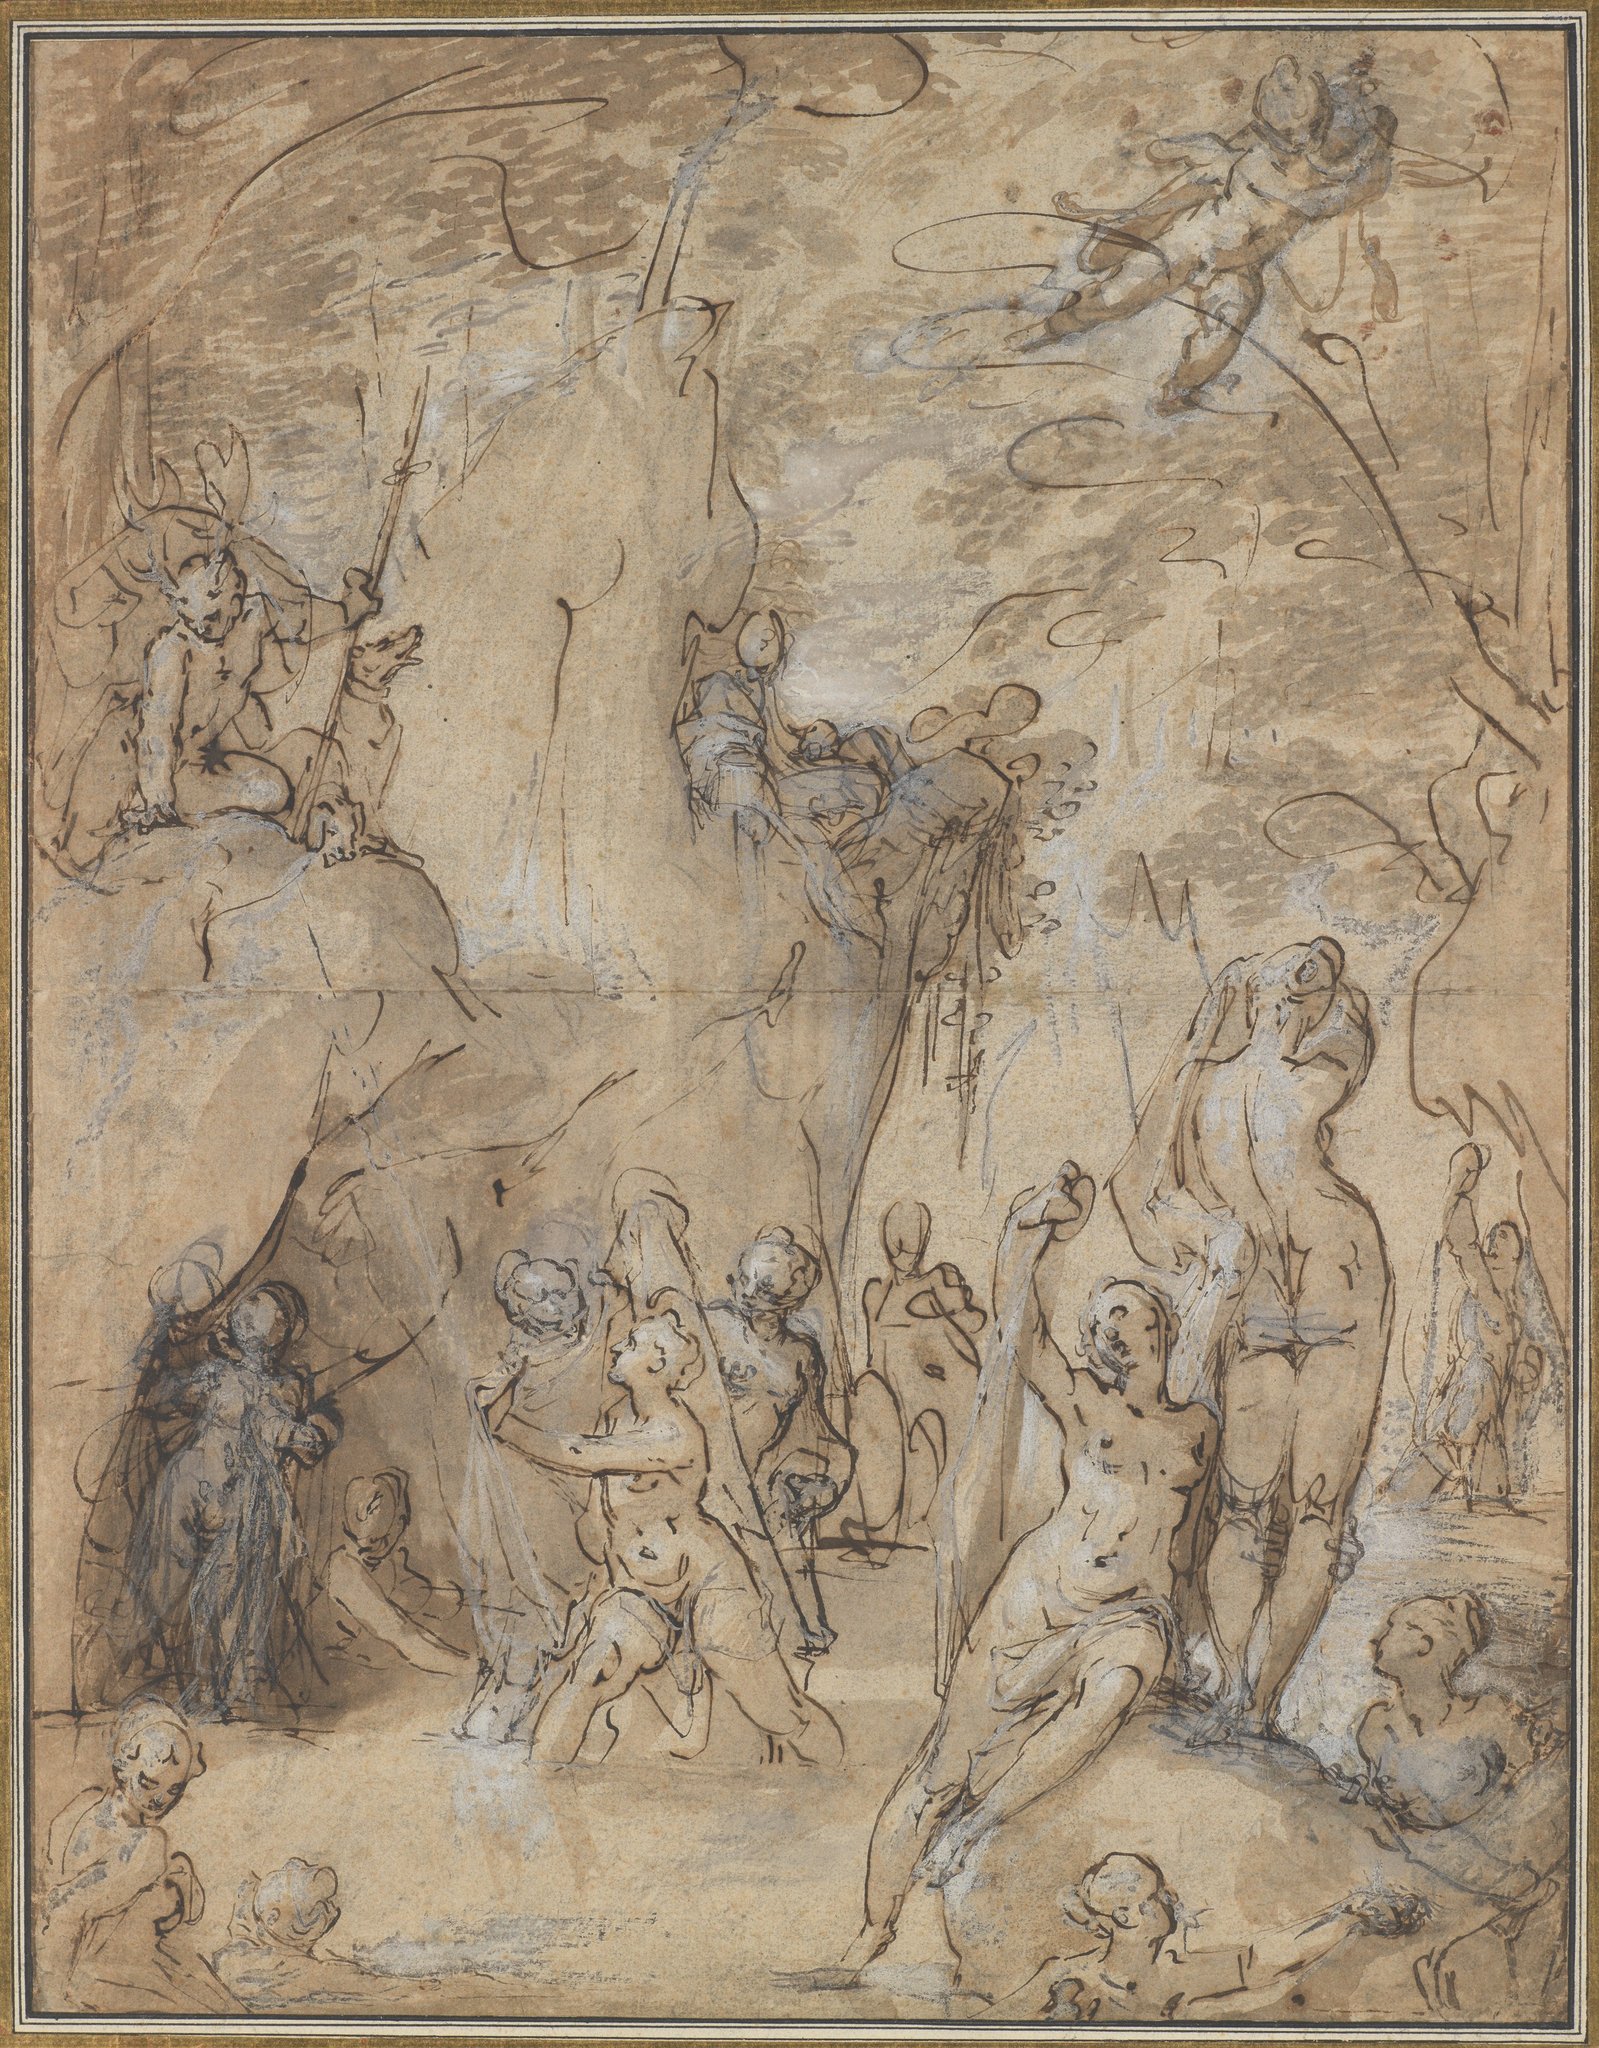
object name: drawing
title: Diana and Actaeon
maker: bartholomeus spranger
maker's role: artist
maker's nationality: netherlandish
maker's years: 1546-1611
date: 1580-1585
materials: chalk, ink, paper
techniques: brush, heightening, pen, wash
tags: actaeon,nymphs,diana,bathing